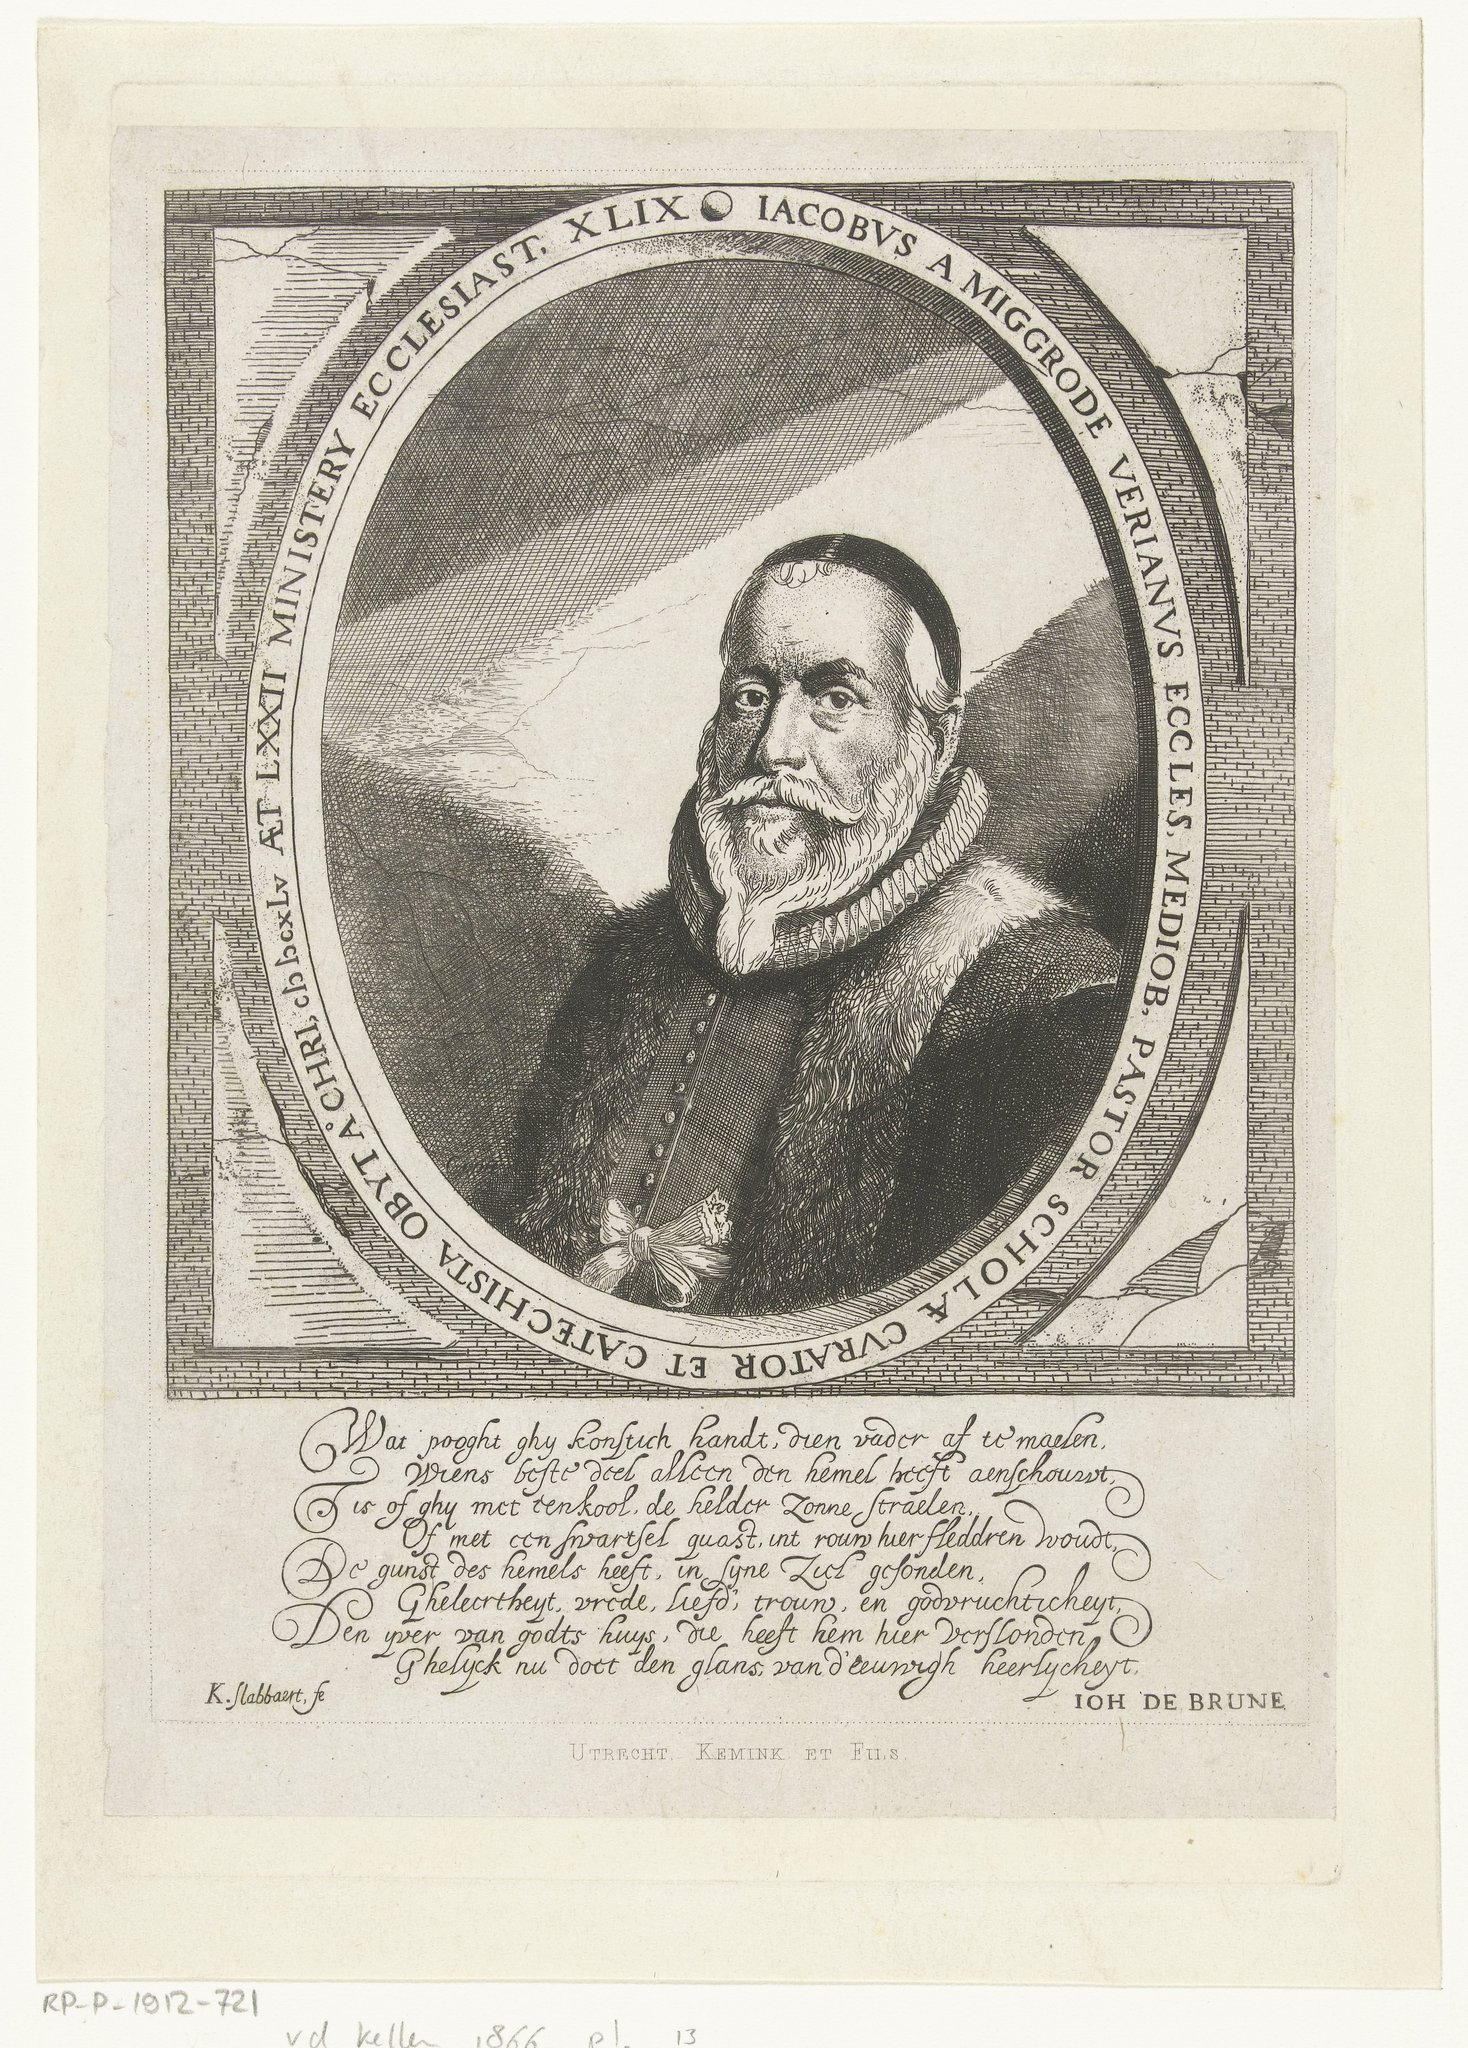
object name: print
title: Portret van Jacobus van Miggrode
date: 1866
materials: paper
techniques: etching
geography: amsterdam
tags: middelburg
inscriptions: collector's mark: Lugt 2228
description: Illustratie voor J.P. van der Kellen, Le peintre graveur hollandais et flamand, Utrecht: 1866.